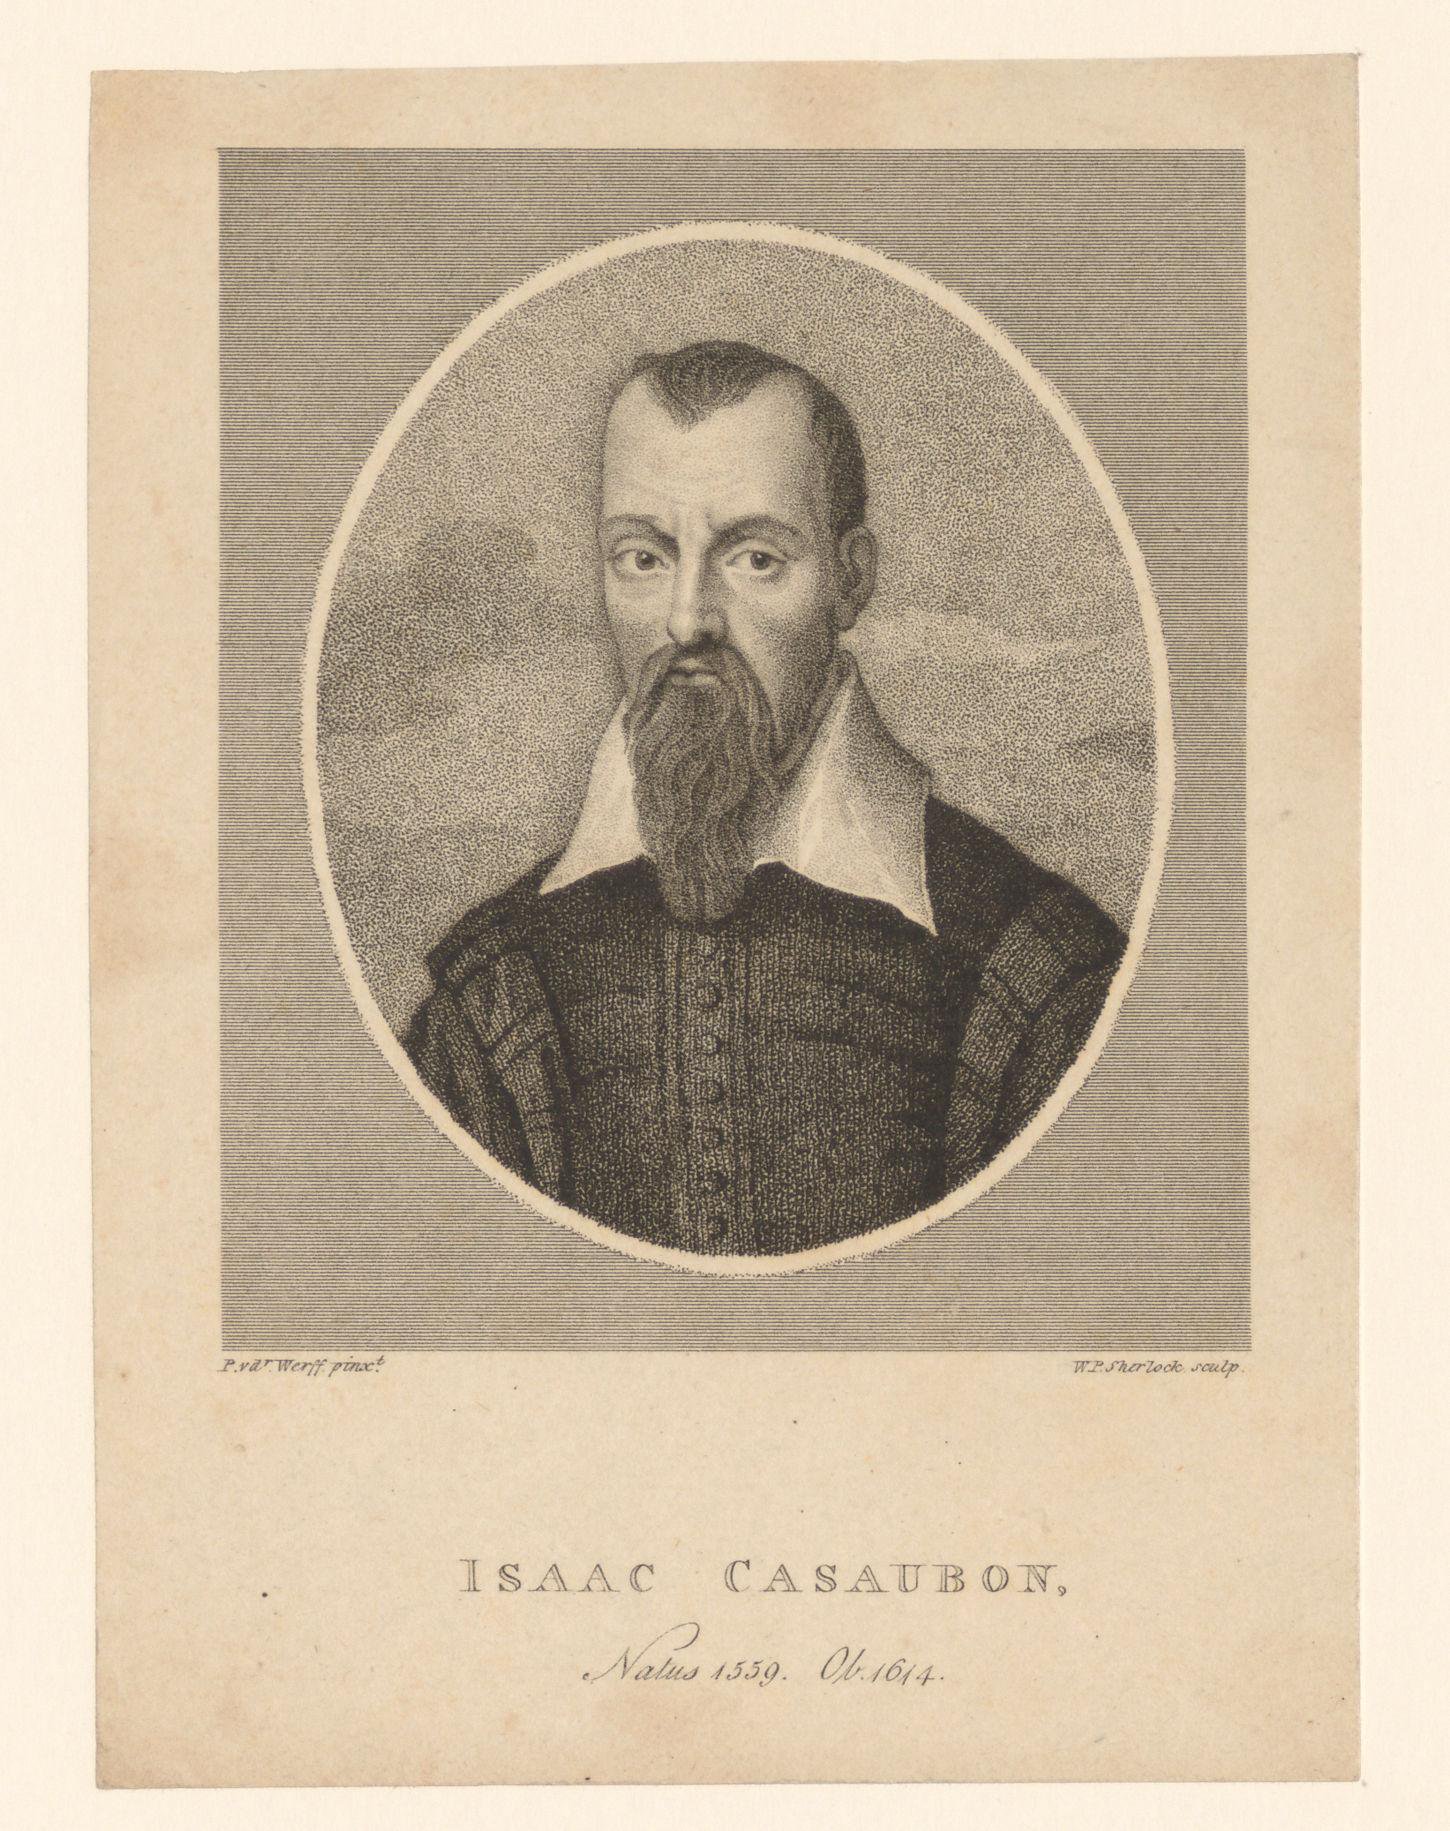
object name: print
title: Portret van Isaac Casaubon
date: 1760-1860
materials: paper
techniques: etching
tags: further education (+ portrait of teacher, professor), historical persons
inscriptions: collector's mark: Lugt 2228